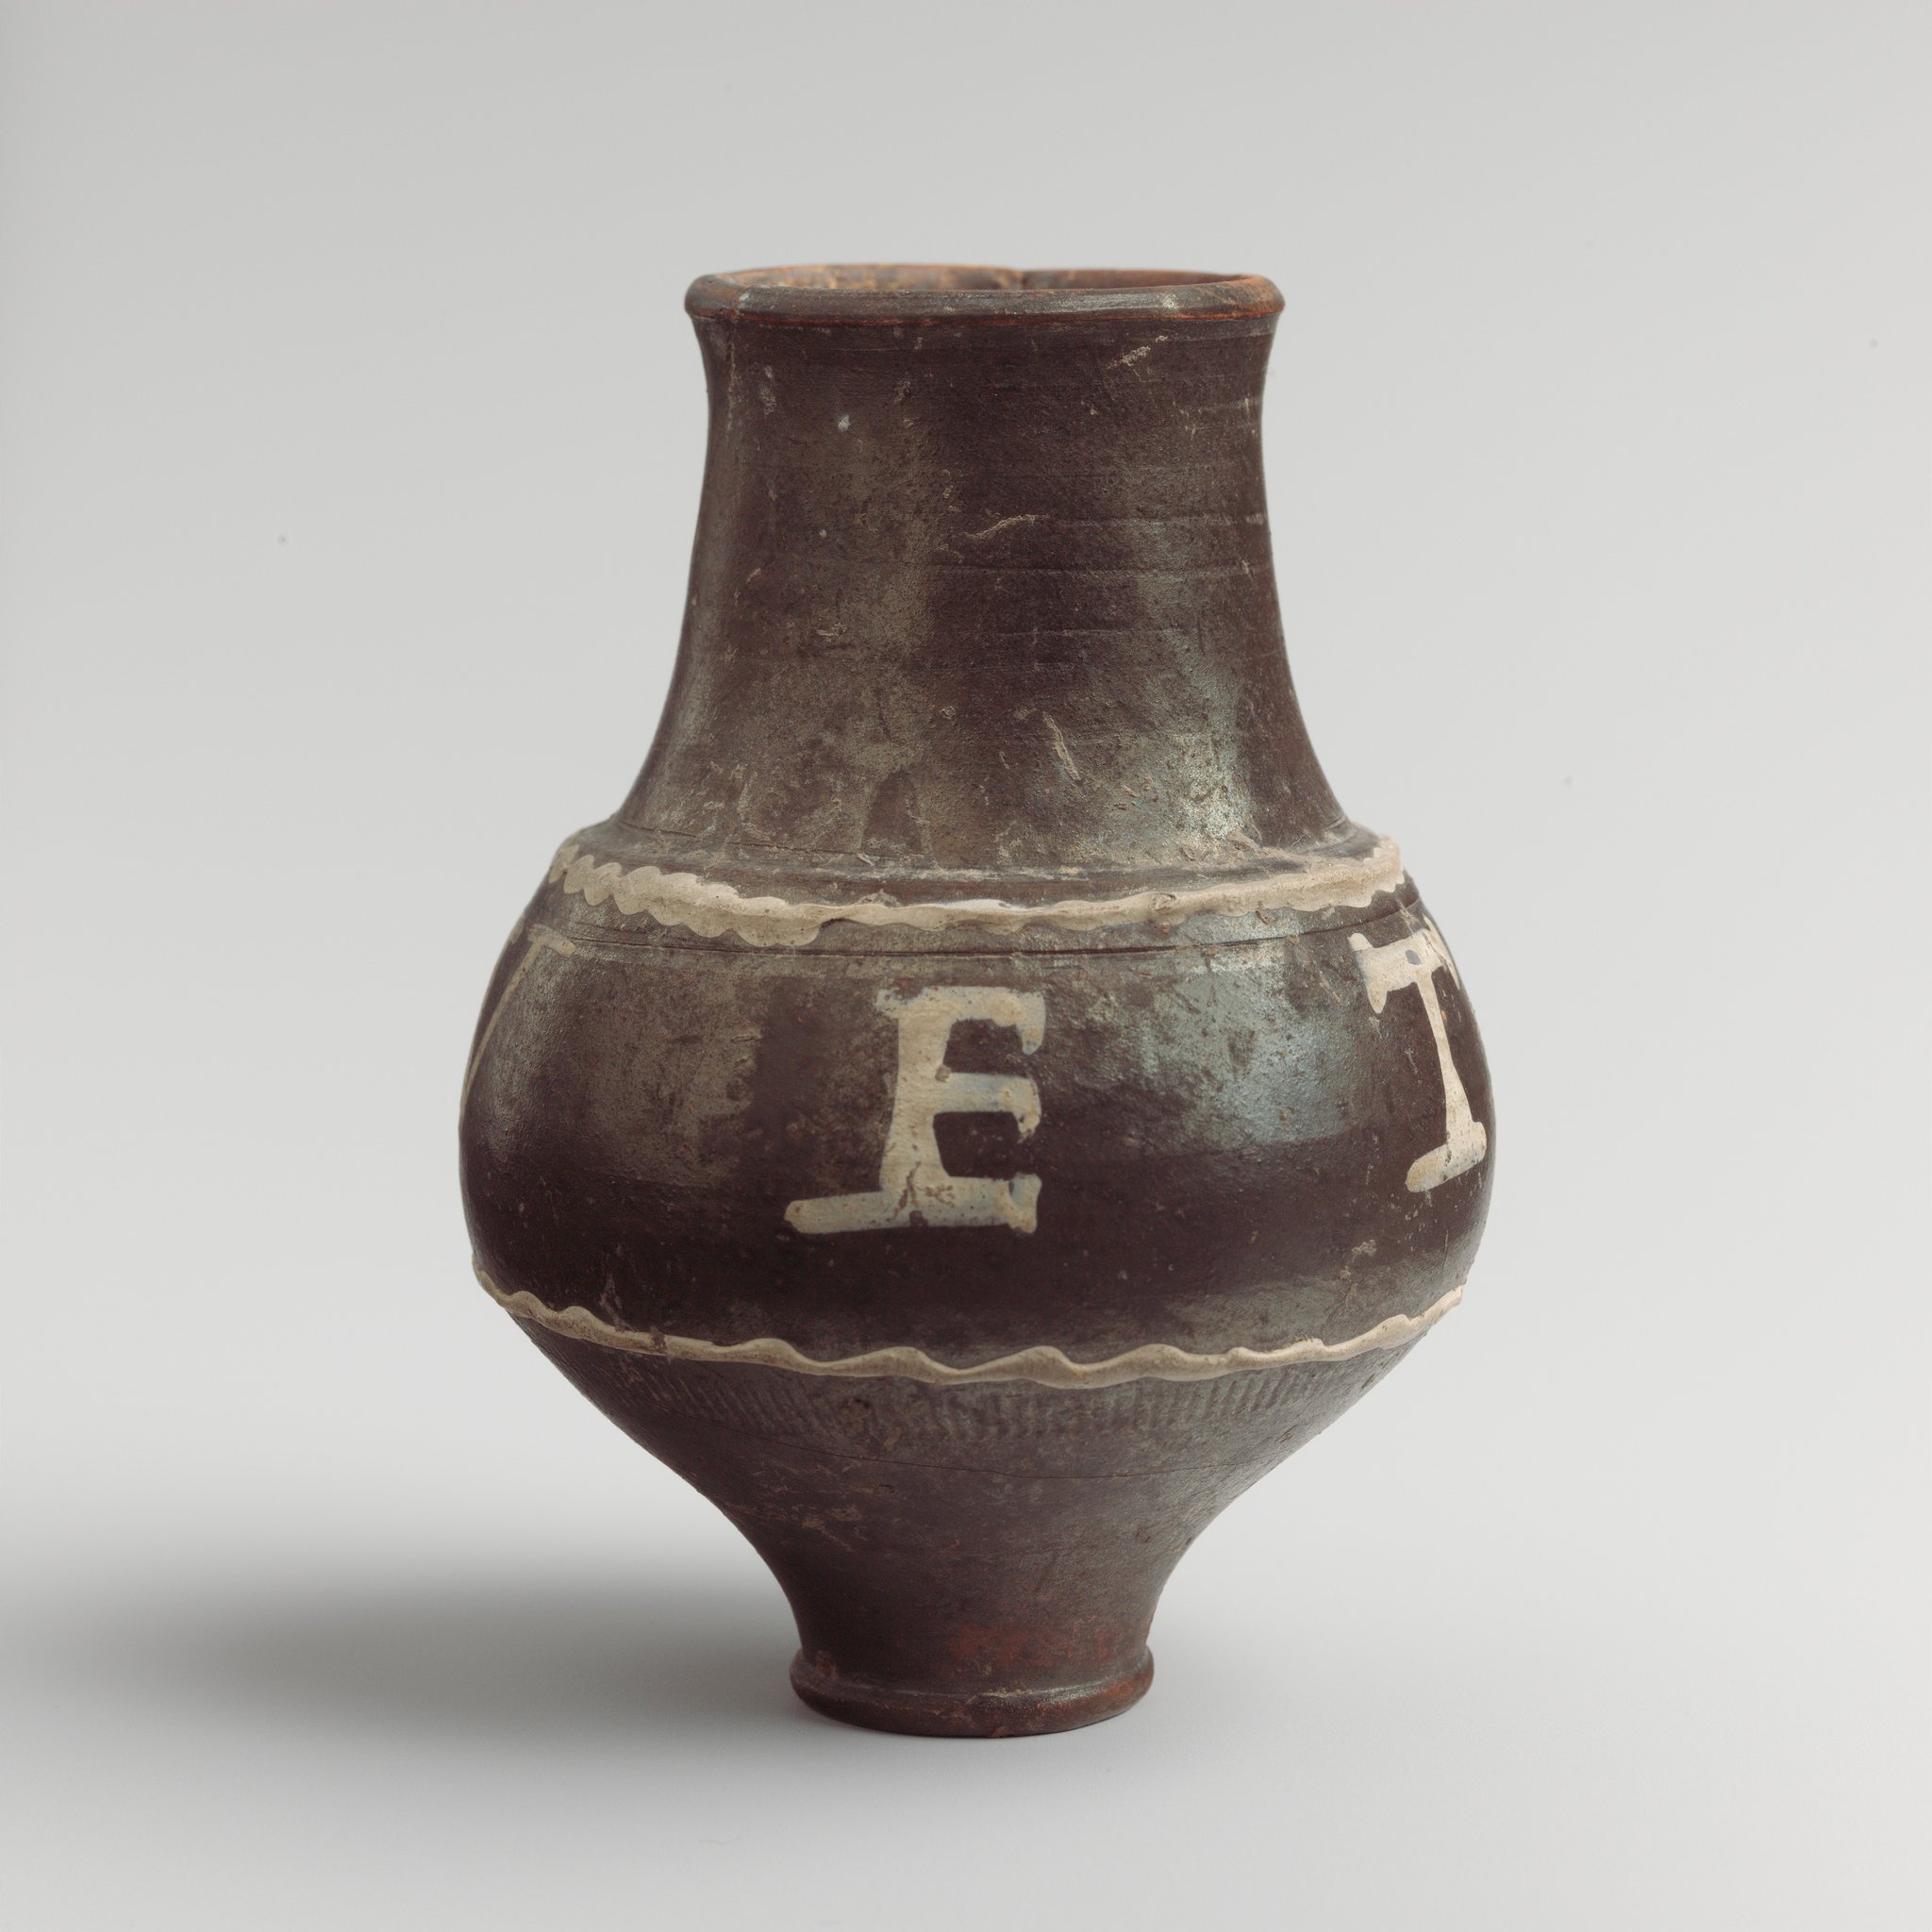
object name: beaker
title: Terracotta beaker with painted inscription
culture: roman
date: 201-300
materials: terracotta